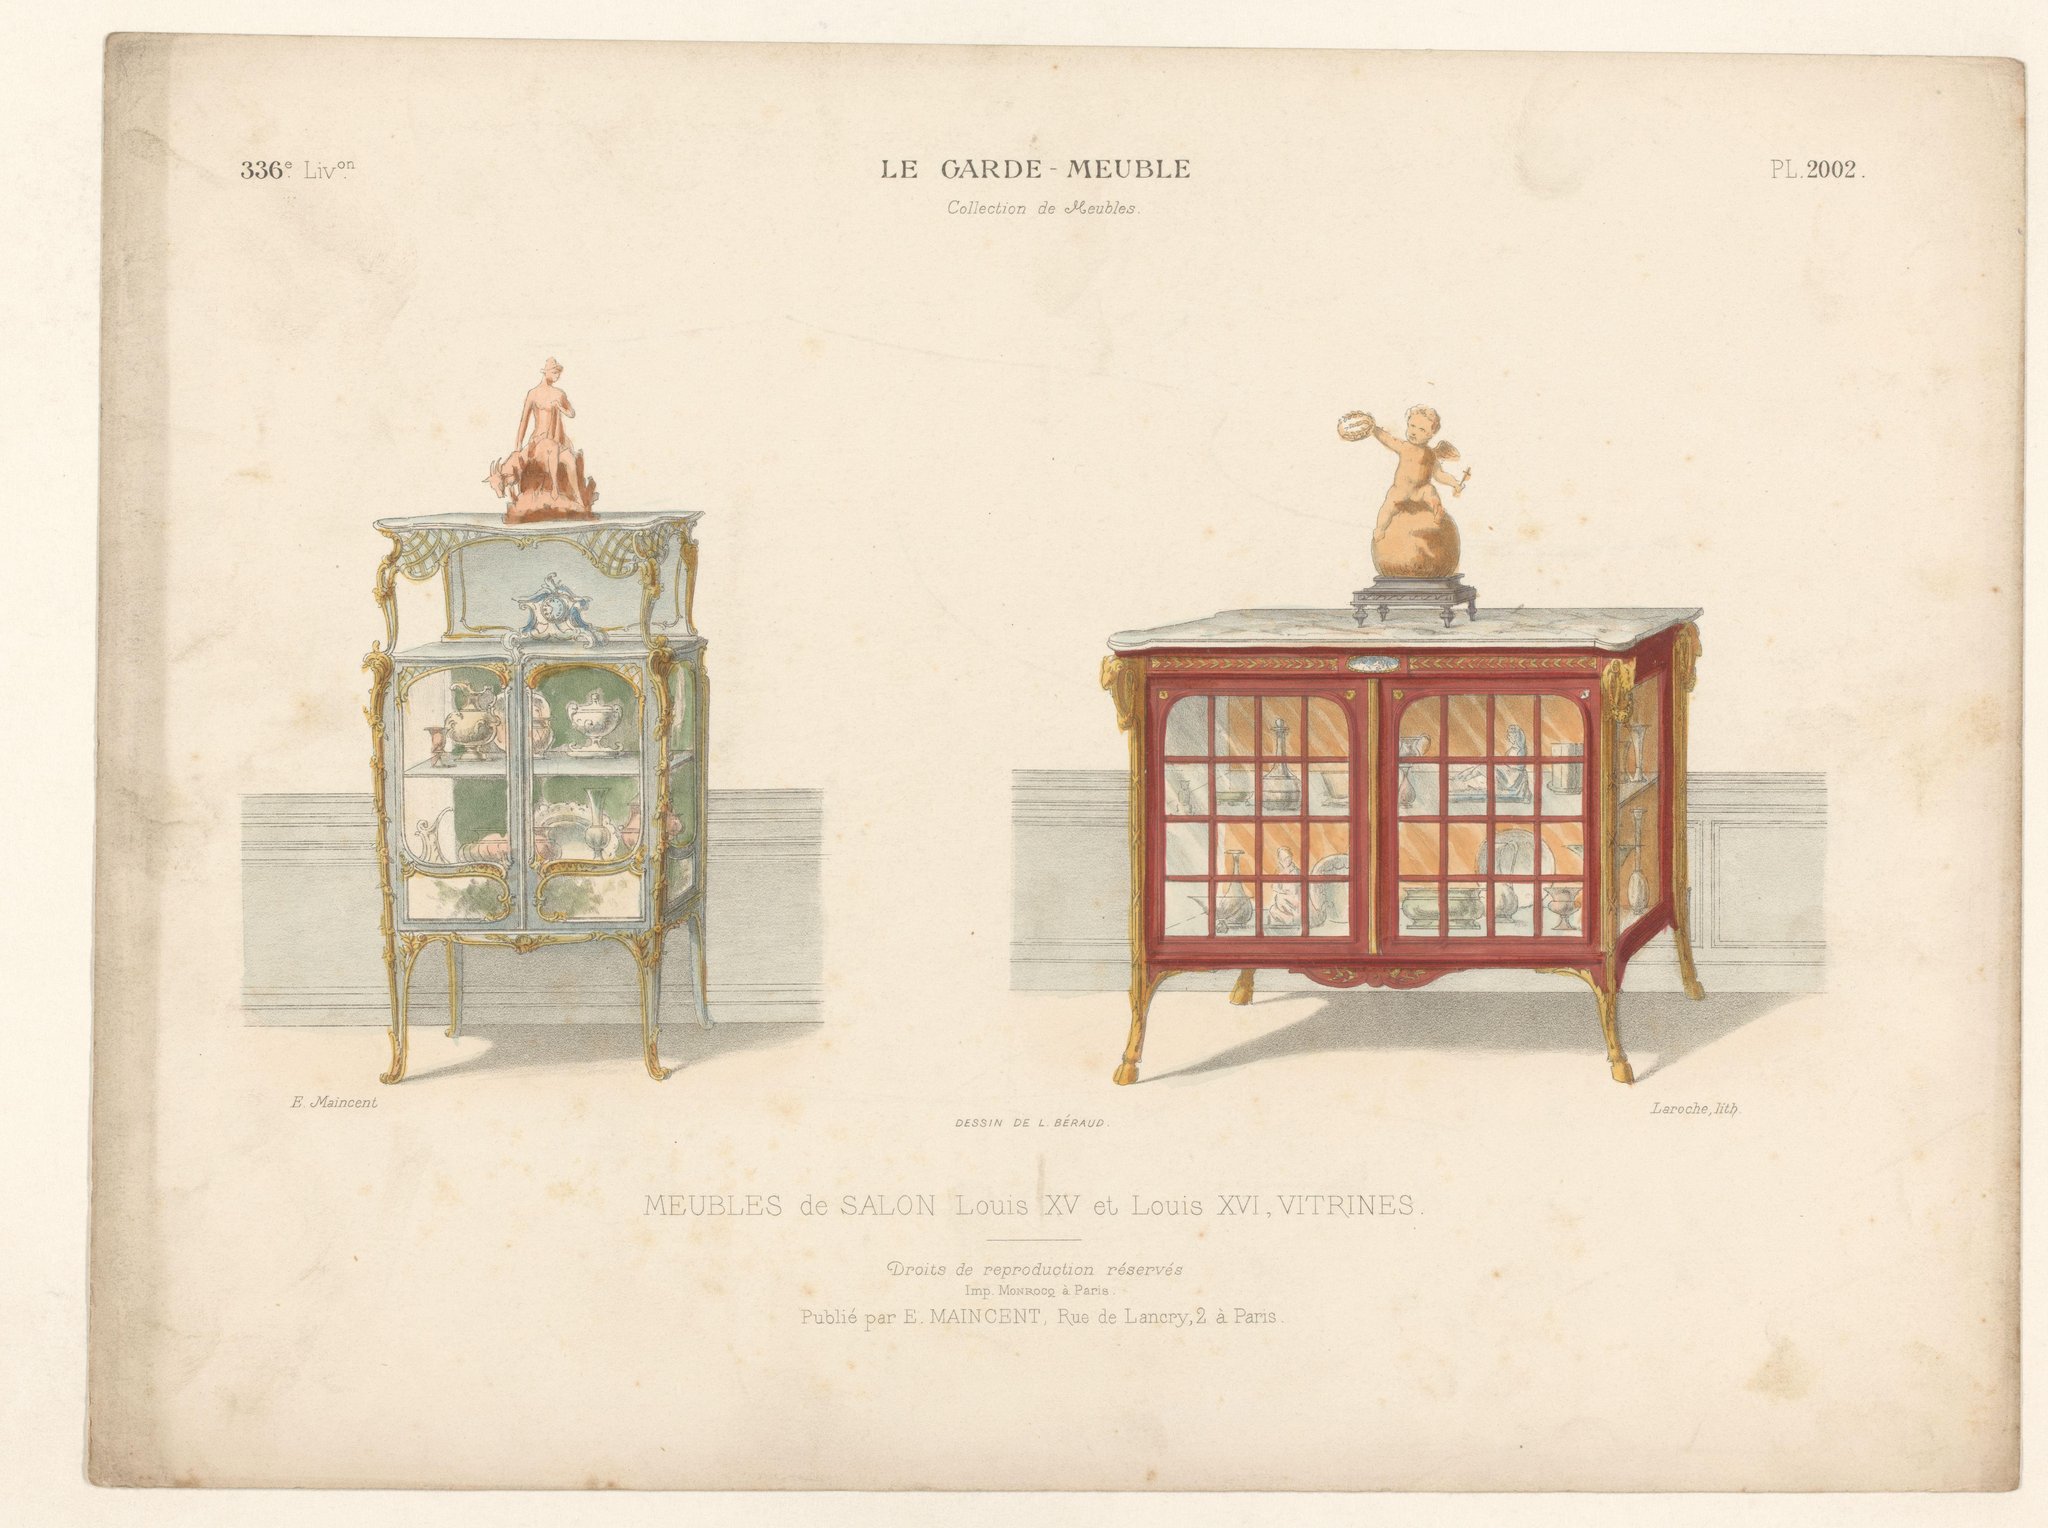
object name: print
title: Le garde-meuble / Collection de Meubles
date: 1885-1895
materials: paper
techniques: hand coloring, lithograph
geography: paris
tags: furniture for storage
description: Ieder Livraison in de serie Le Garde-Meuble bevat negen platen: drie 'sièges' (zitmeubels), drie 'meubles' (diverse meubels zoals tafels en kasten) en drie 'tentures' (gordijnen en draperieën).